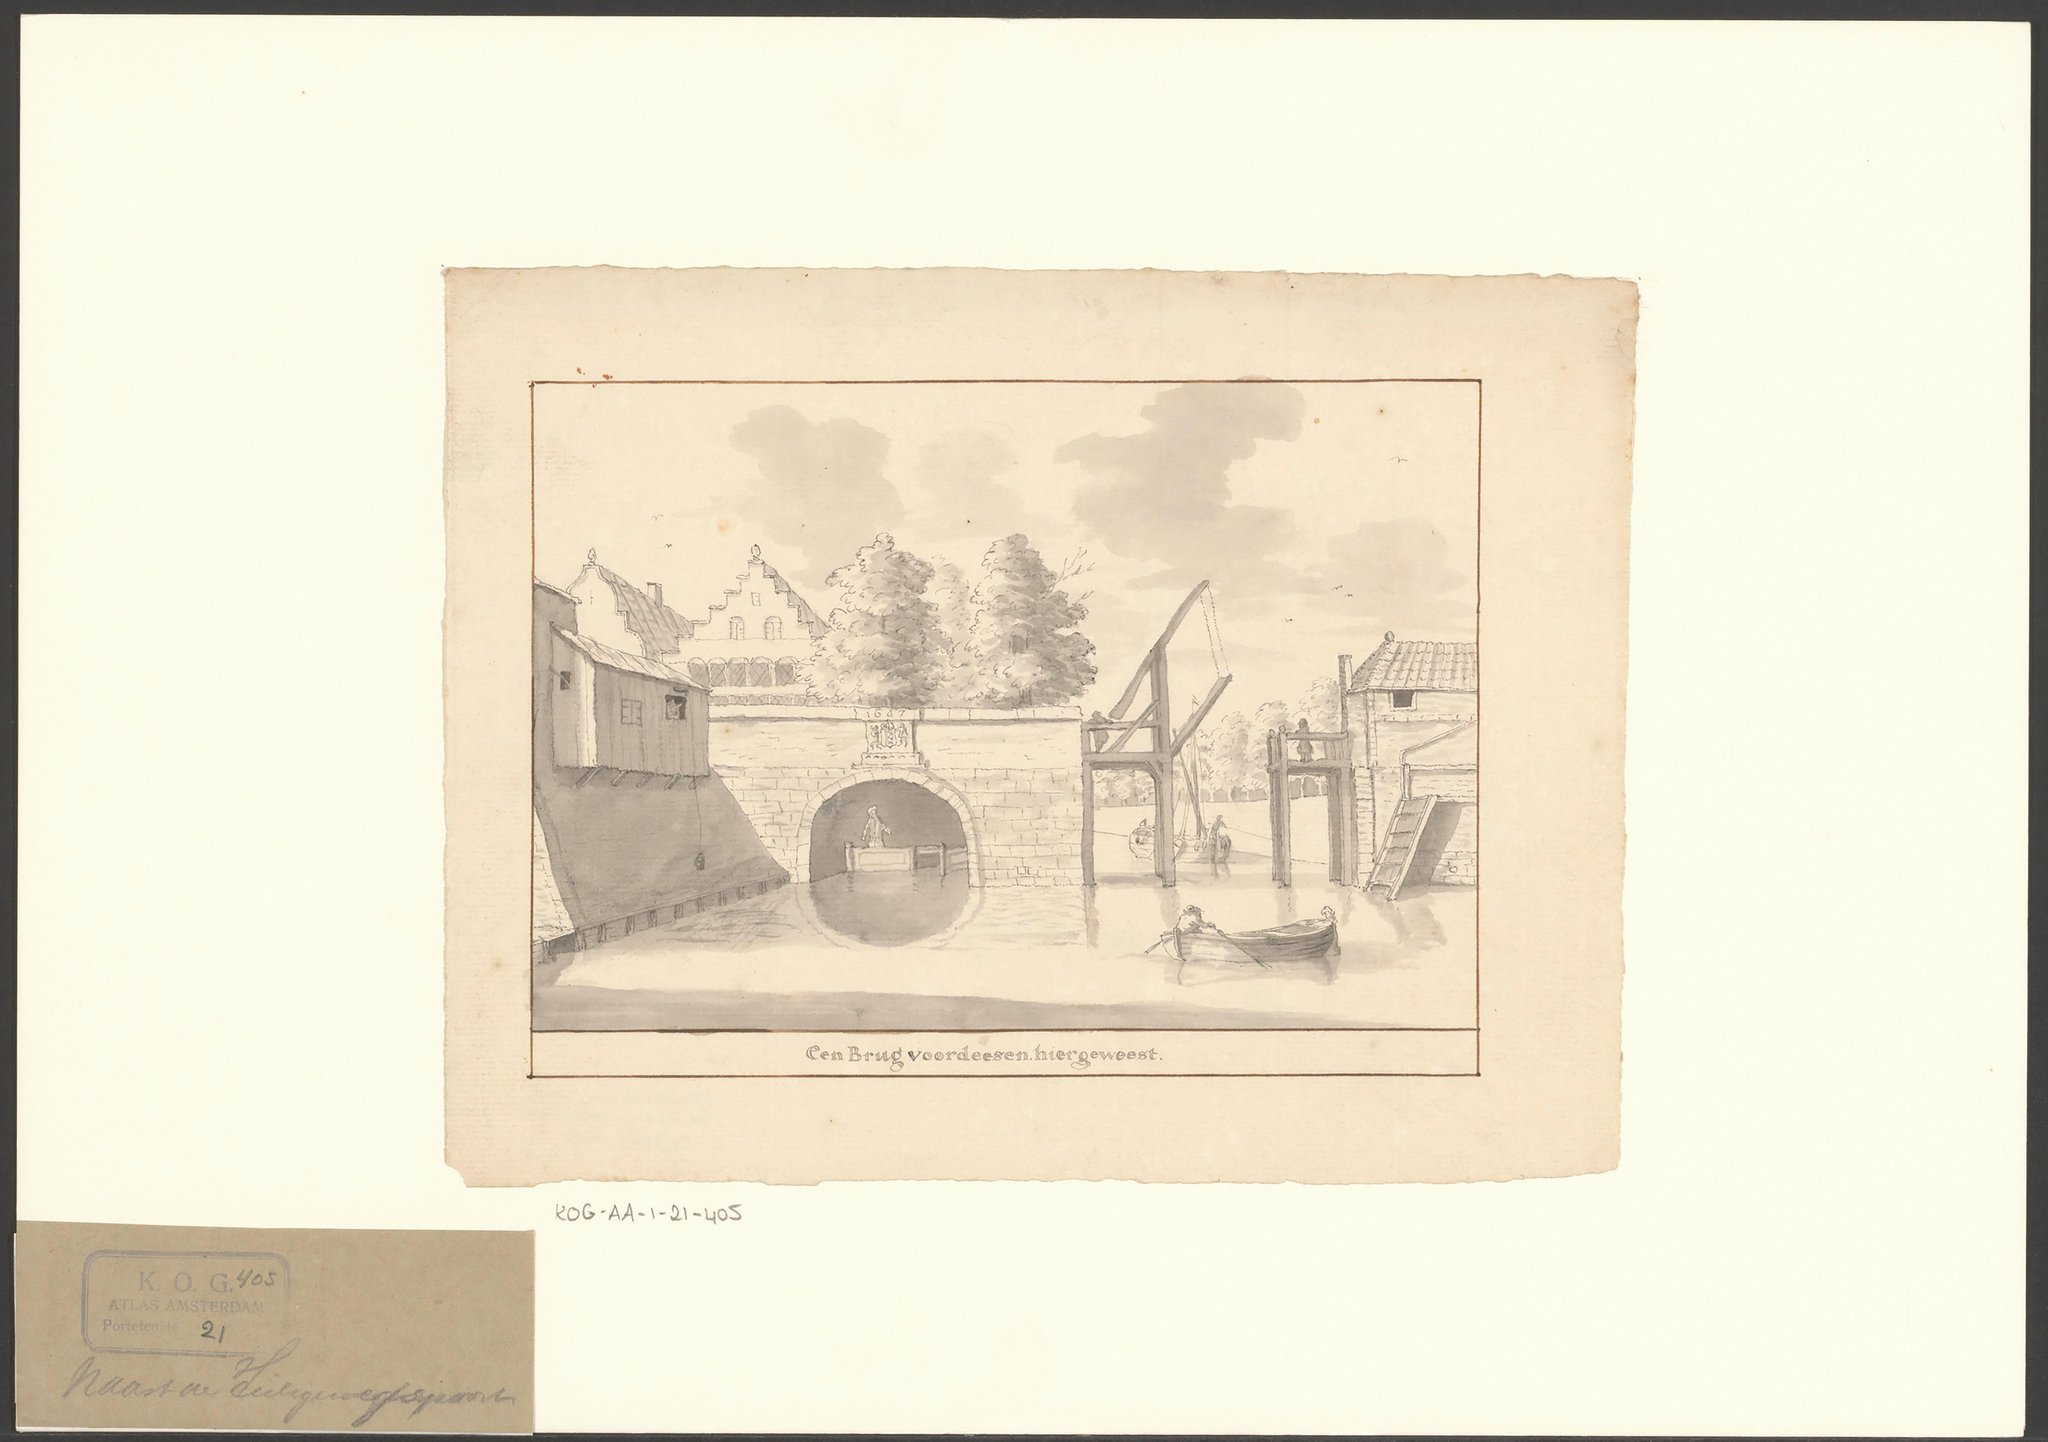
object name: drawing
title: Gezicht op een brug over het Singel naast de Heiligewegspoort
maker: Anonymous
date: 1800-1850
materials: ink, paper, pencil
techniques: brush, pen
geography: amsterdam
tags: city-view in general; 'veduta', river, bridge in city across river, canal, etc.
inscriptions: inscription: ‘naast de Heiligenwegspoort. / Geschenk van den / gemeente Utrecht / April 1877’, inscription: ‘Port. 21-405’, inscription: ‘Een Brug voordeesen.hiergeweest.’, collector's mark: ‘21’ Lugt 1641b